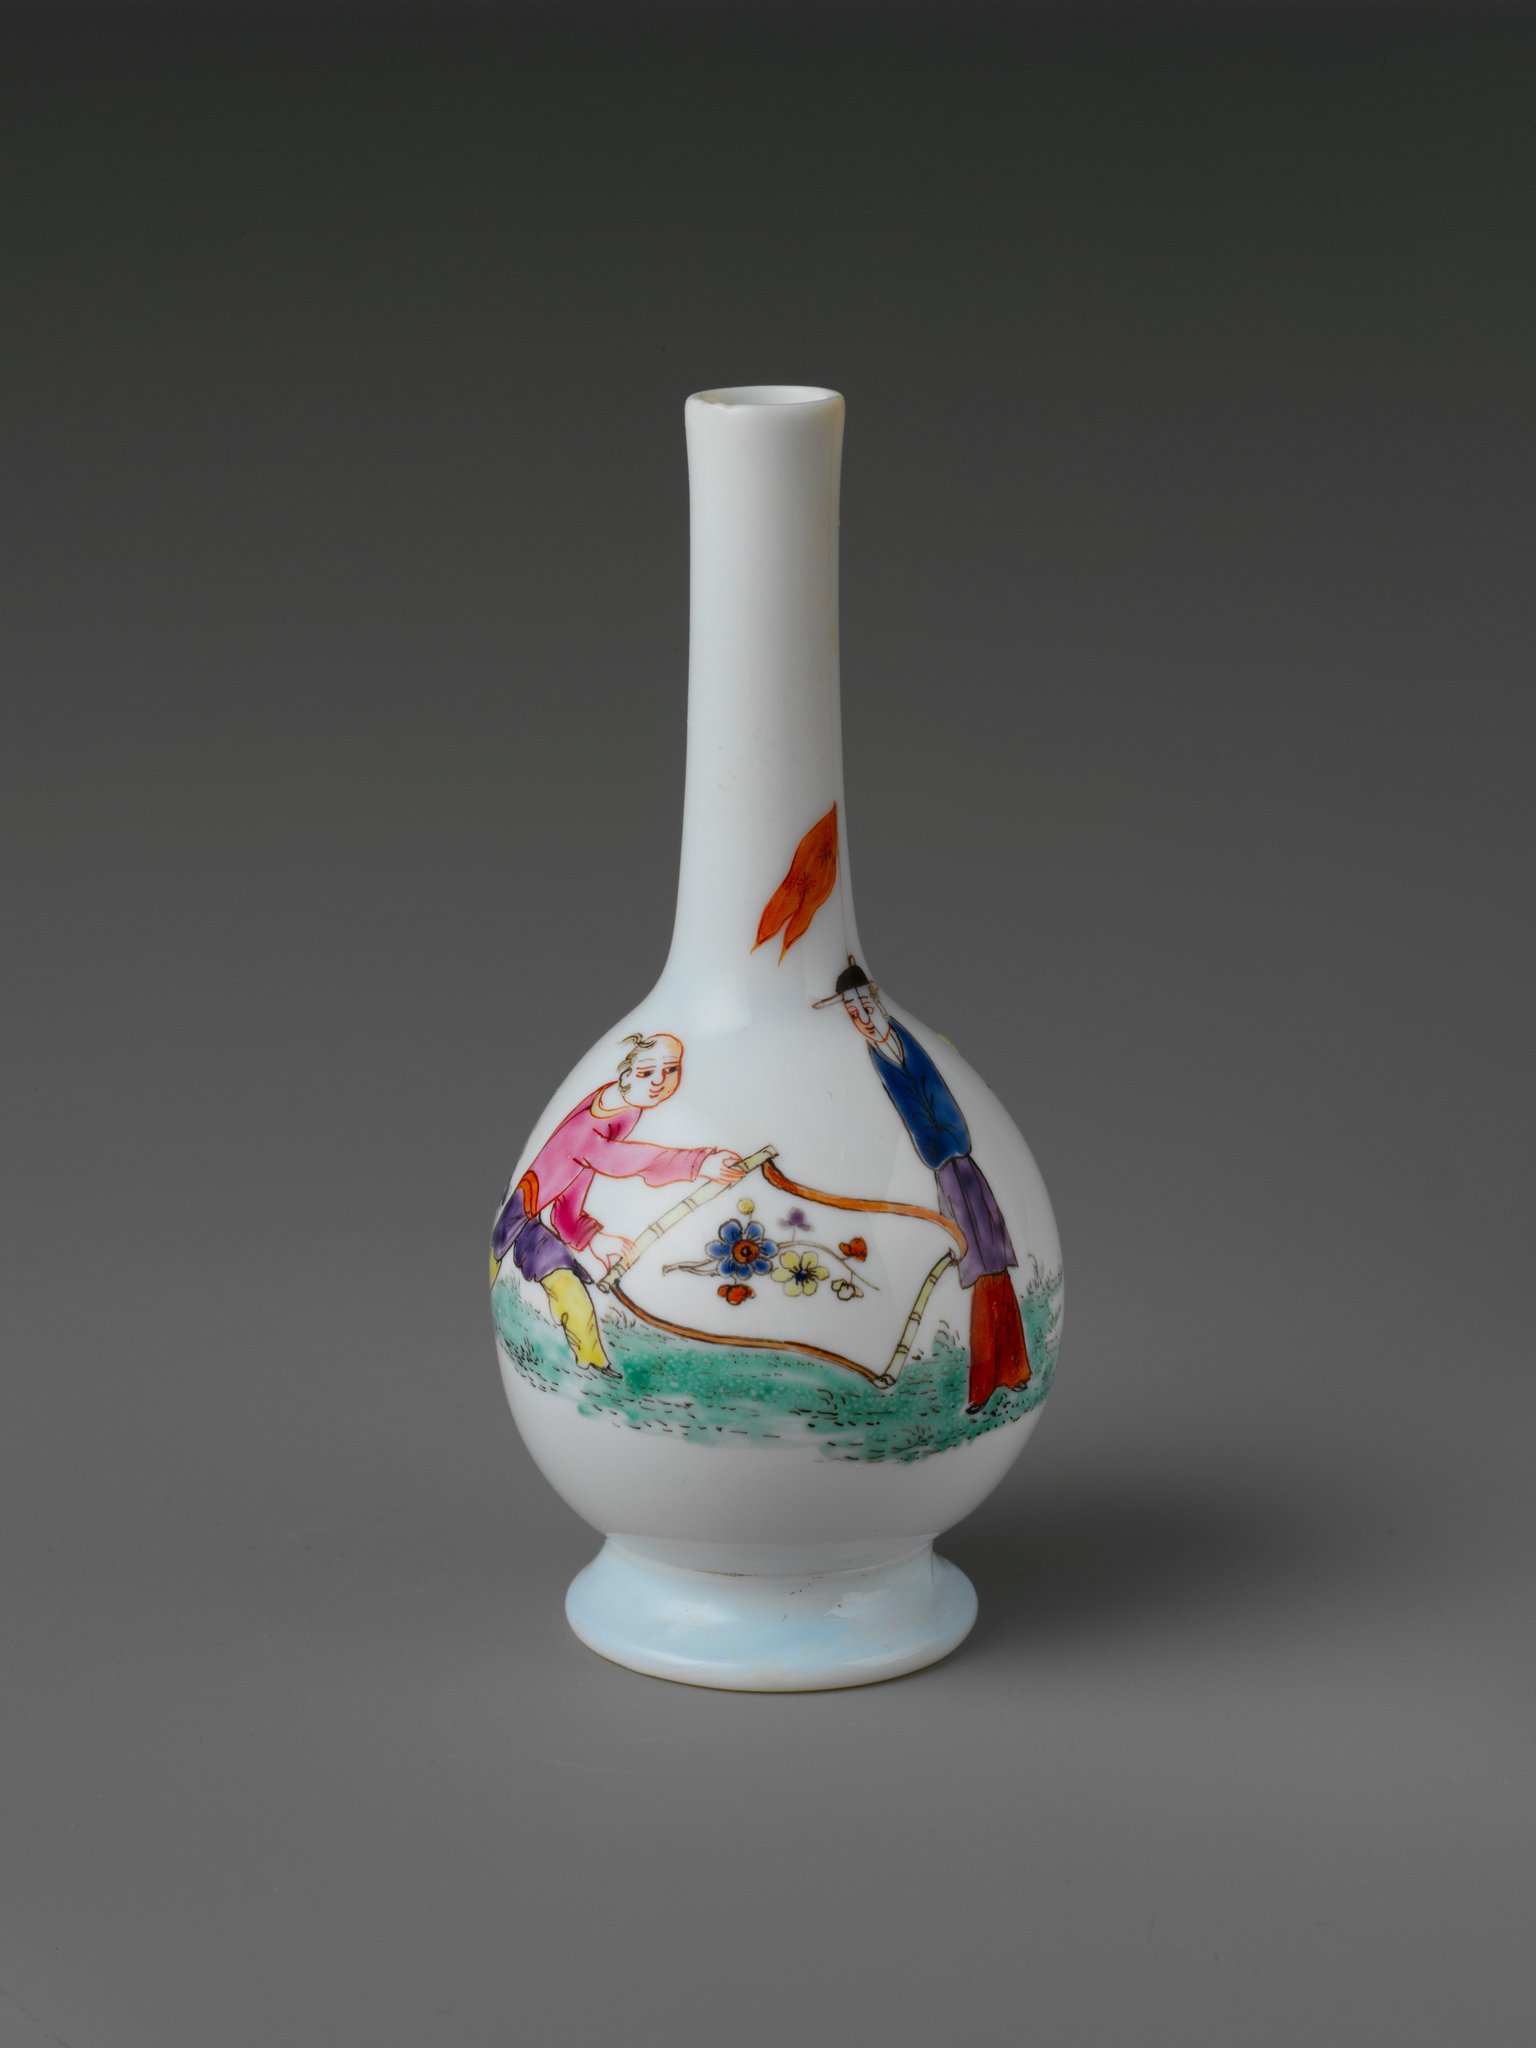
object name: bottle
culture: british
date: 1760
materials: enamel, glass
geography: england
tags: men